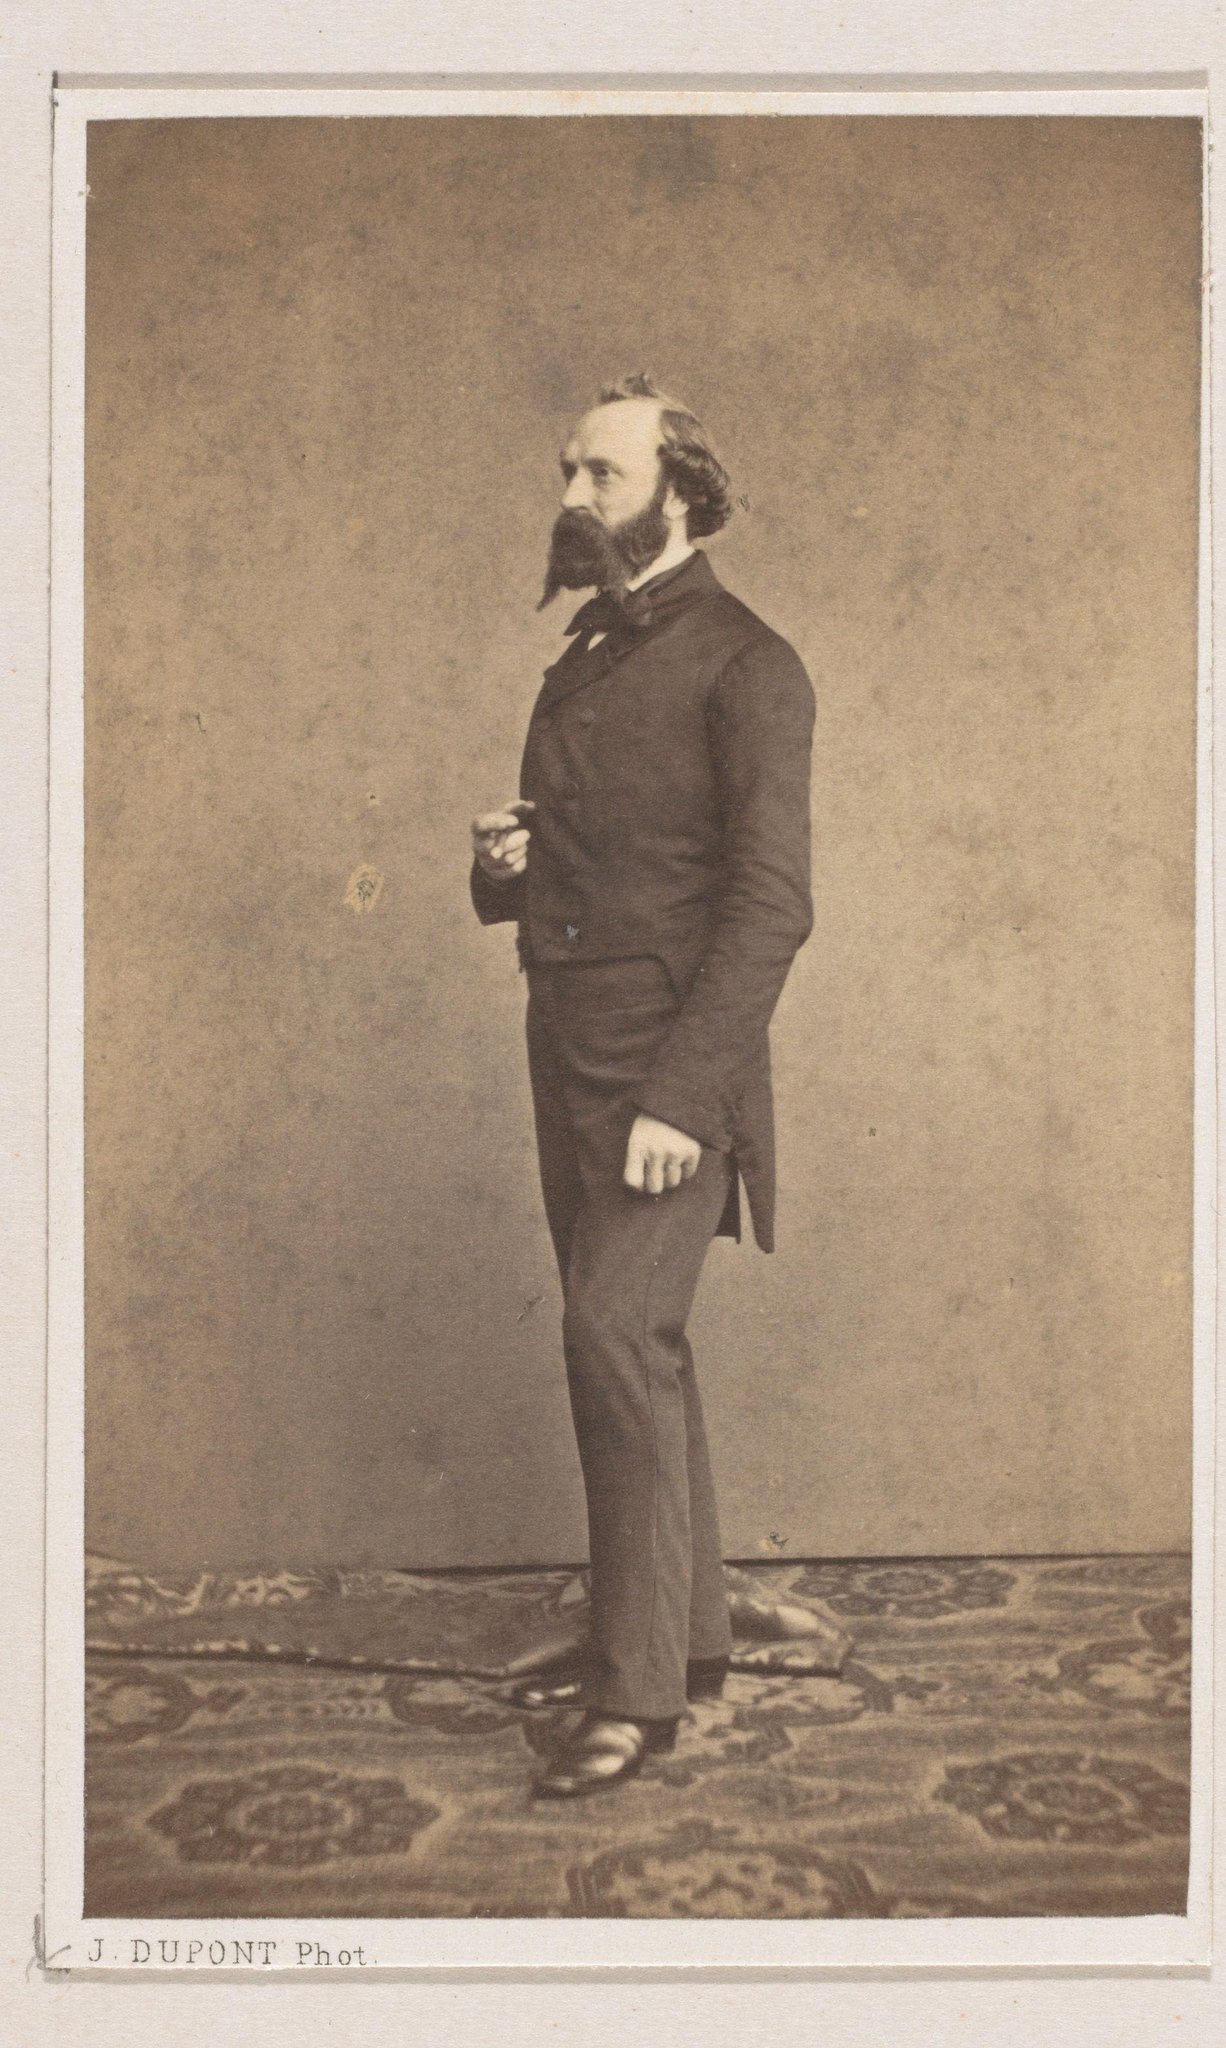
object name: carte de visite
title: Portret van de schilder August de Wilde, ten voeten uit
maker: joseph dupont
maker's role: fotograaf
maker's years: 1818-1901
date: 1861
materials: cardboard, paper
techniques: albumen print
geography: antwerp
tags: painter, historical persons, portrait, self-portrait of painter, portrait, self-portrait of artist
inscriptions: inscription: ‘ETABLISSEMENT PHOTOGRAPHIQUE/ de/ J. DUPONT/ Place de Meir 32/ ANVERS/ Maison fondée en 1853’, inscription: ‘De Wilde’